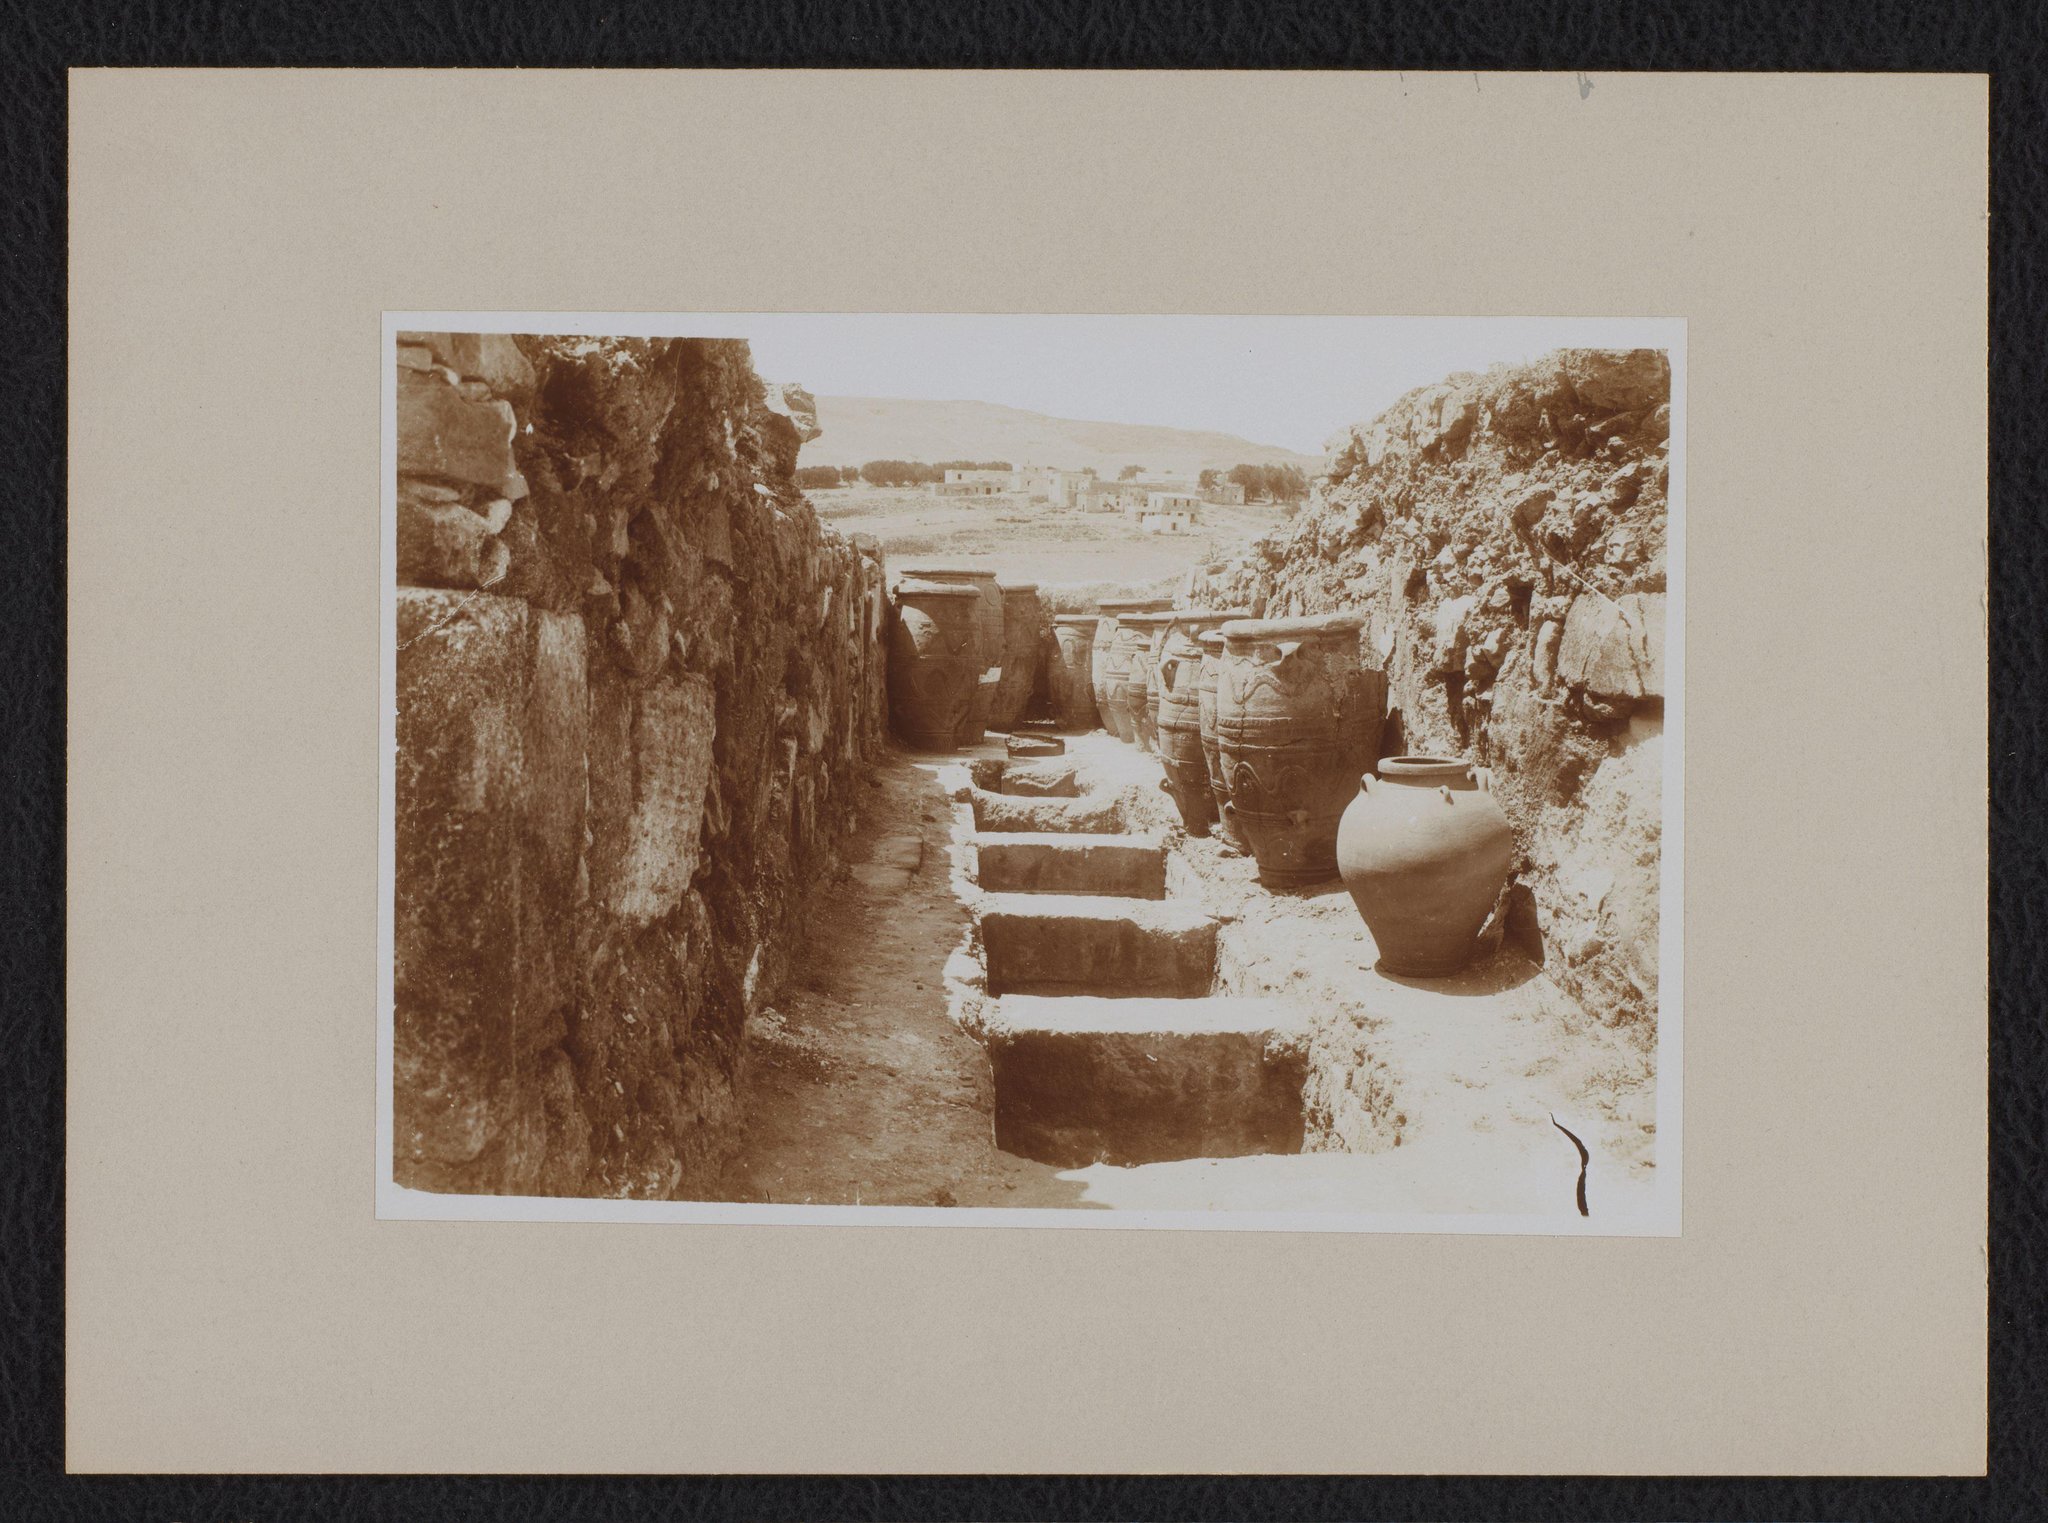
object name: photograph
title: Voorraadmagazijn in het Paleis van Knossos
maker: Anonymous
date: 1895-1915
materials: cardboard, paper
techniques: gelatin silver print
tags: knossós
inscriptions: annotation: ‘51. Kreta. paleis van Cnossos voorraadsmagazijn’